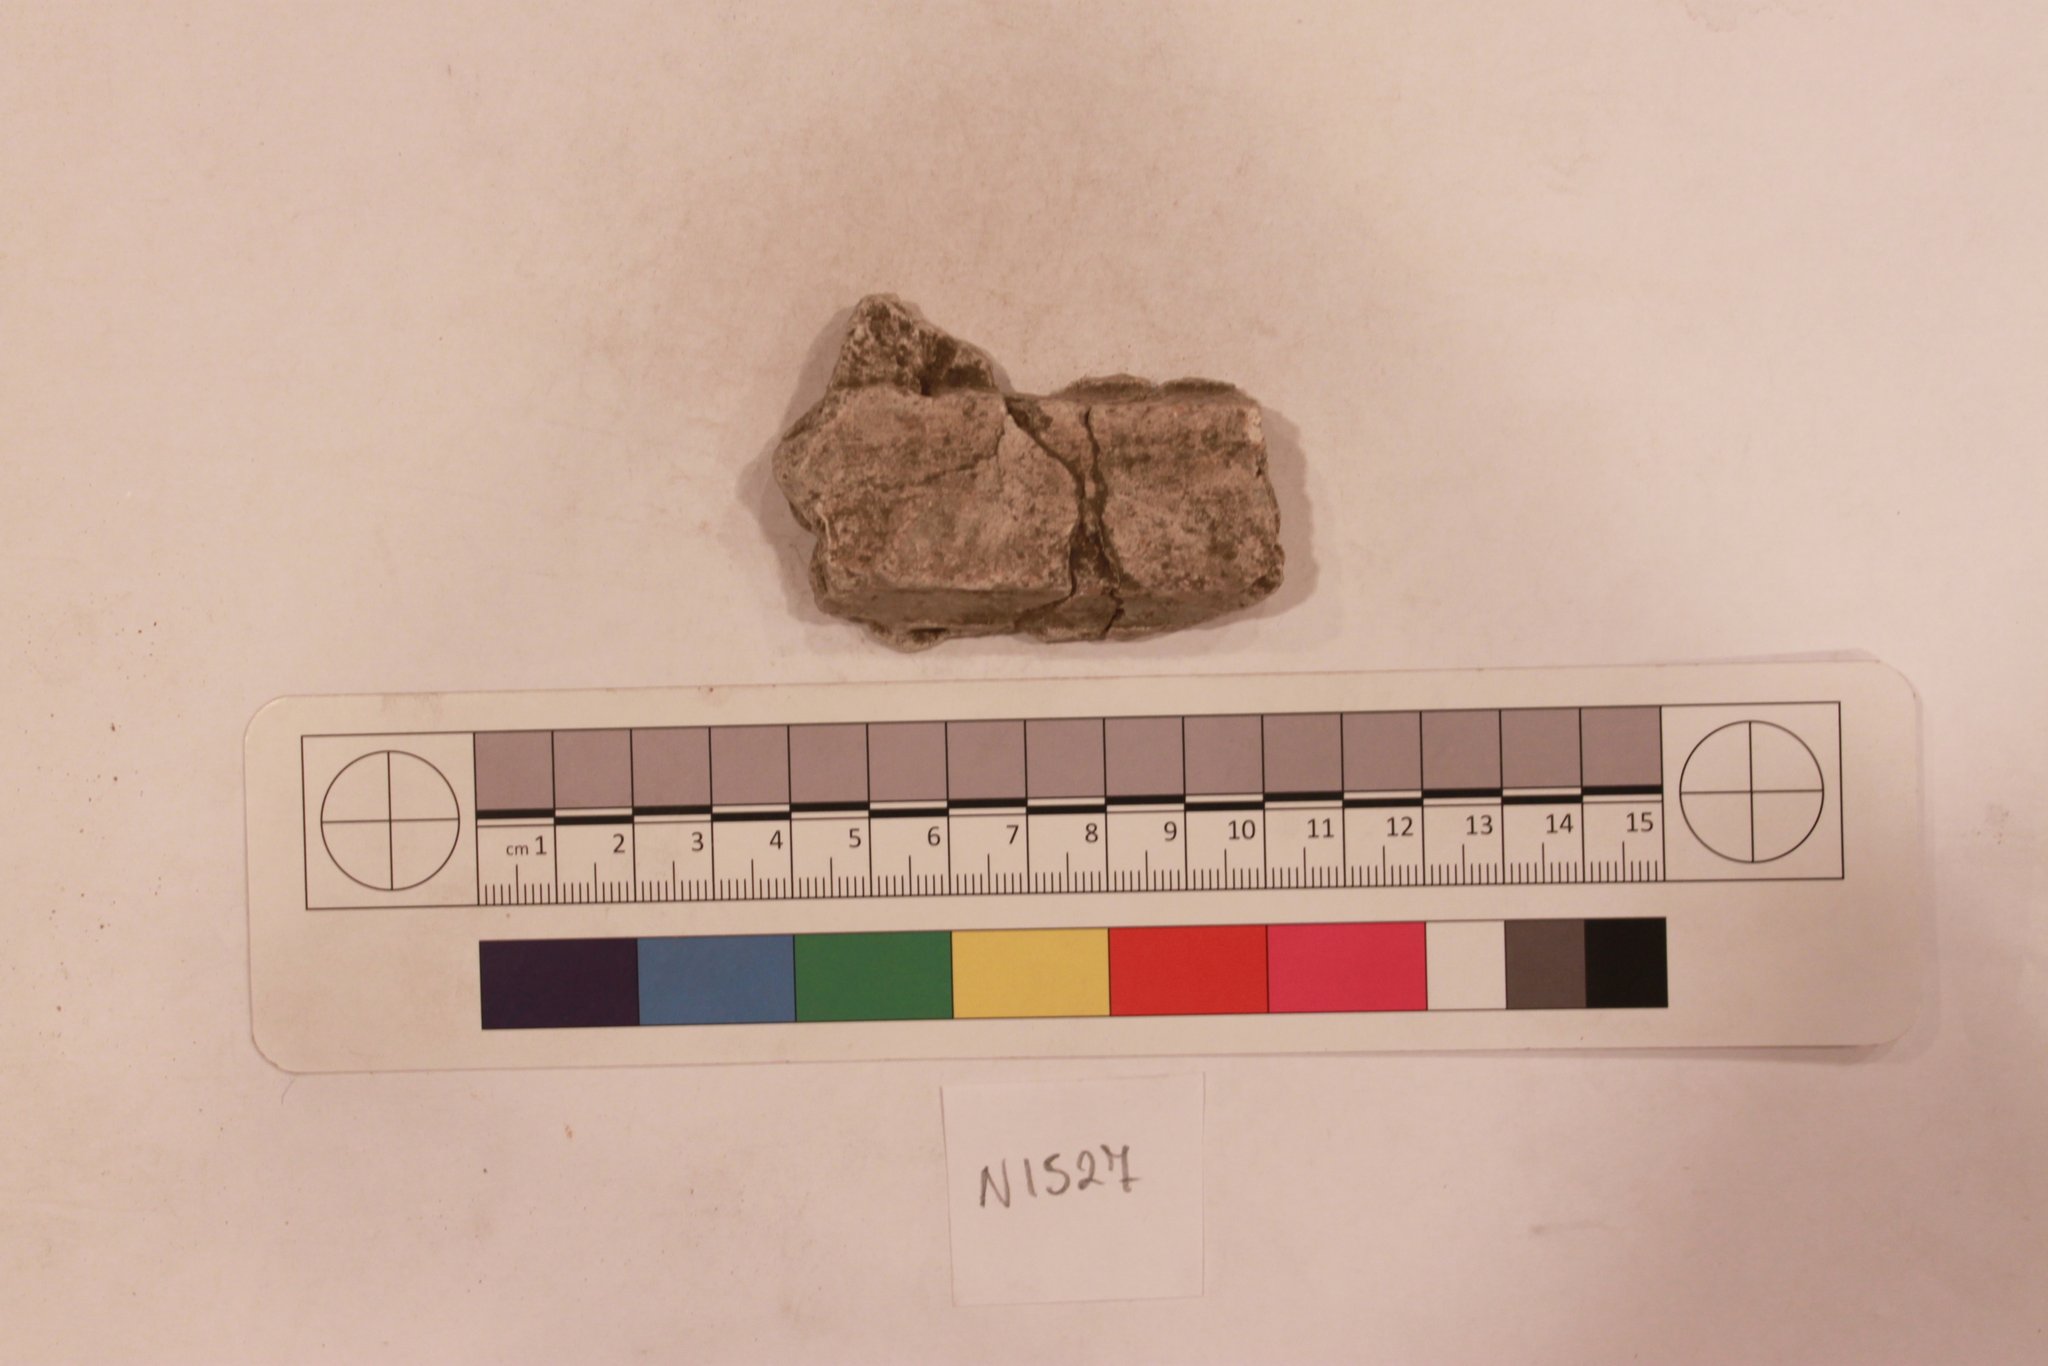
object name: fragment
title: Stucco Fragment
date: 701-1200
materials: plaster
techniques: carving, painting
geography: iran